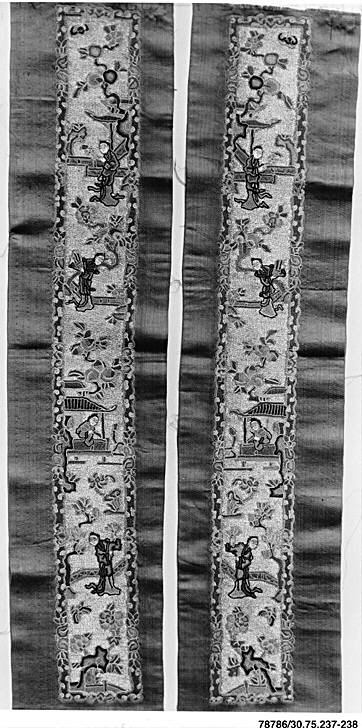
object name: sleeve band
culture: chinese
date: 1801-1900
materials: metal thread, silk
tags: human figures